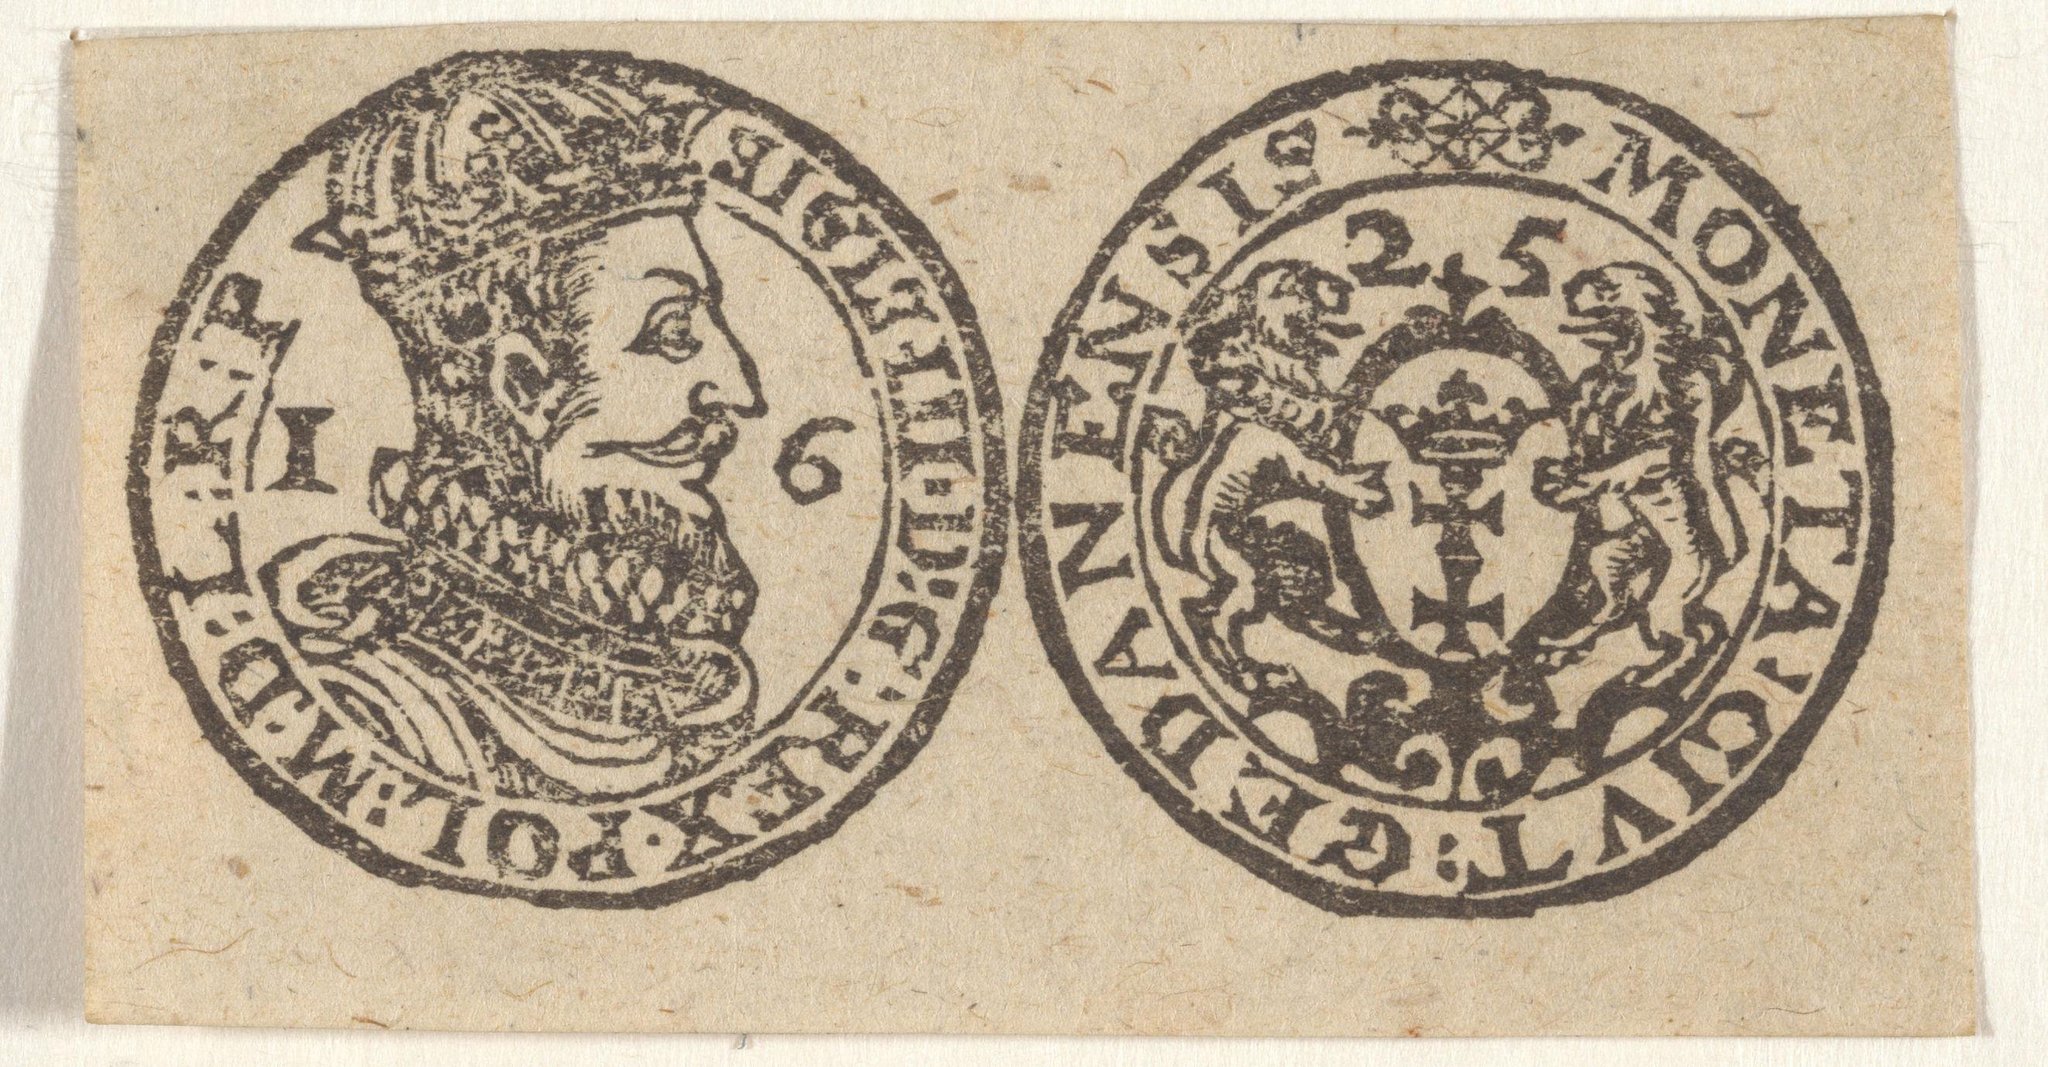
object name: print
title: Penning met portret van Sigismund III, koning van Polen en Zweden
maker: Anonymous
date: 1625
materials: paper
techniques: woodcut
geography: netherlands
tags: sigismund iii (koning van polen), coin, armorial bearing, heraldry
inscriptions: collector's mark: Lugt 240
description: Portret van Sigismund III in een cirkel met randschrift links. Zijn wapen met twee leeuwen in een cirkel met randschrift rechts.